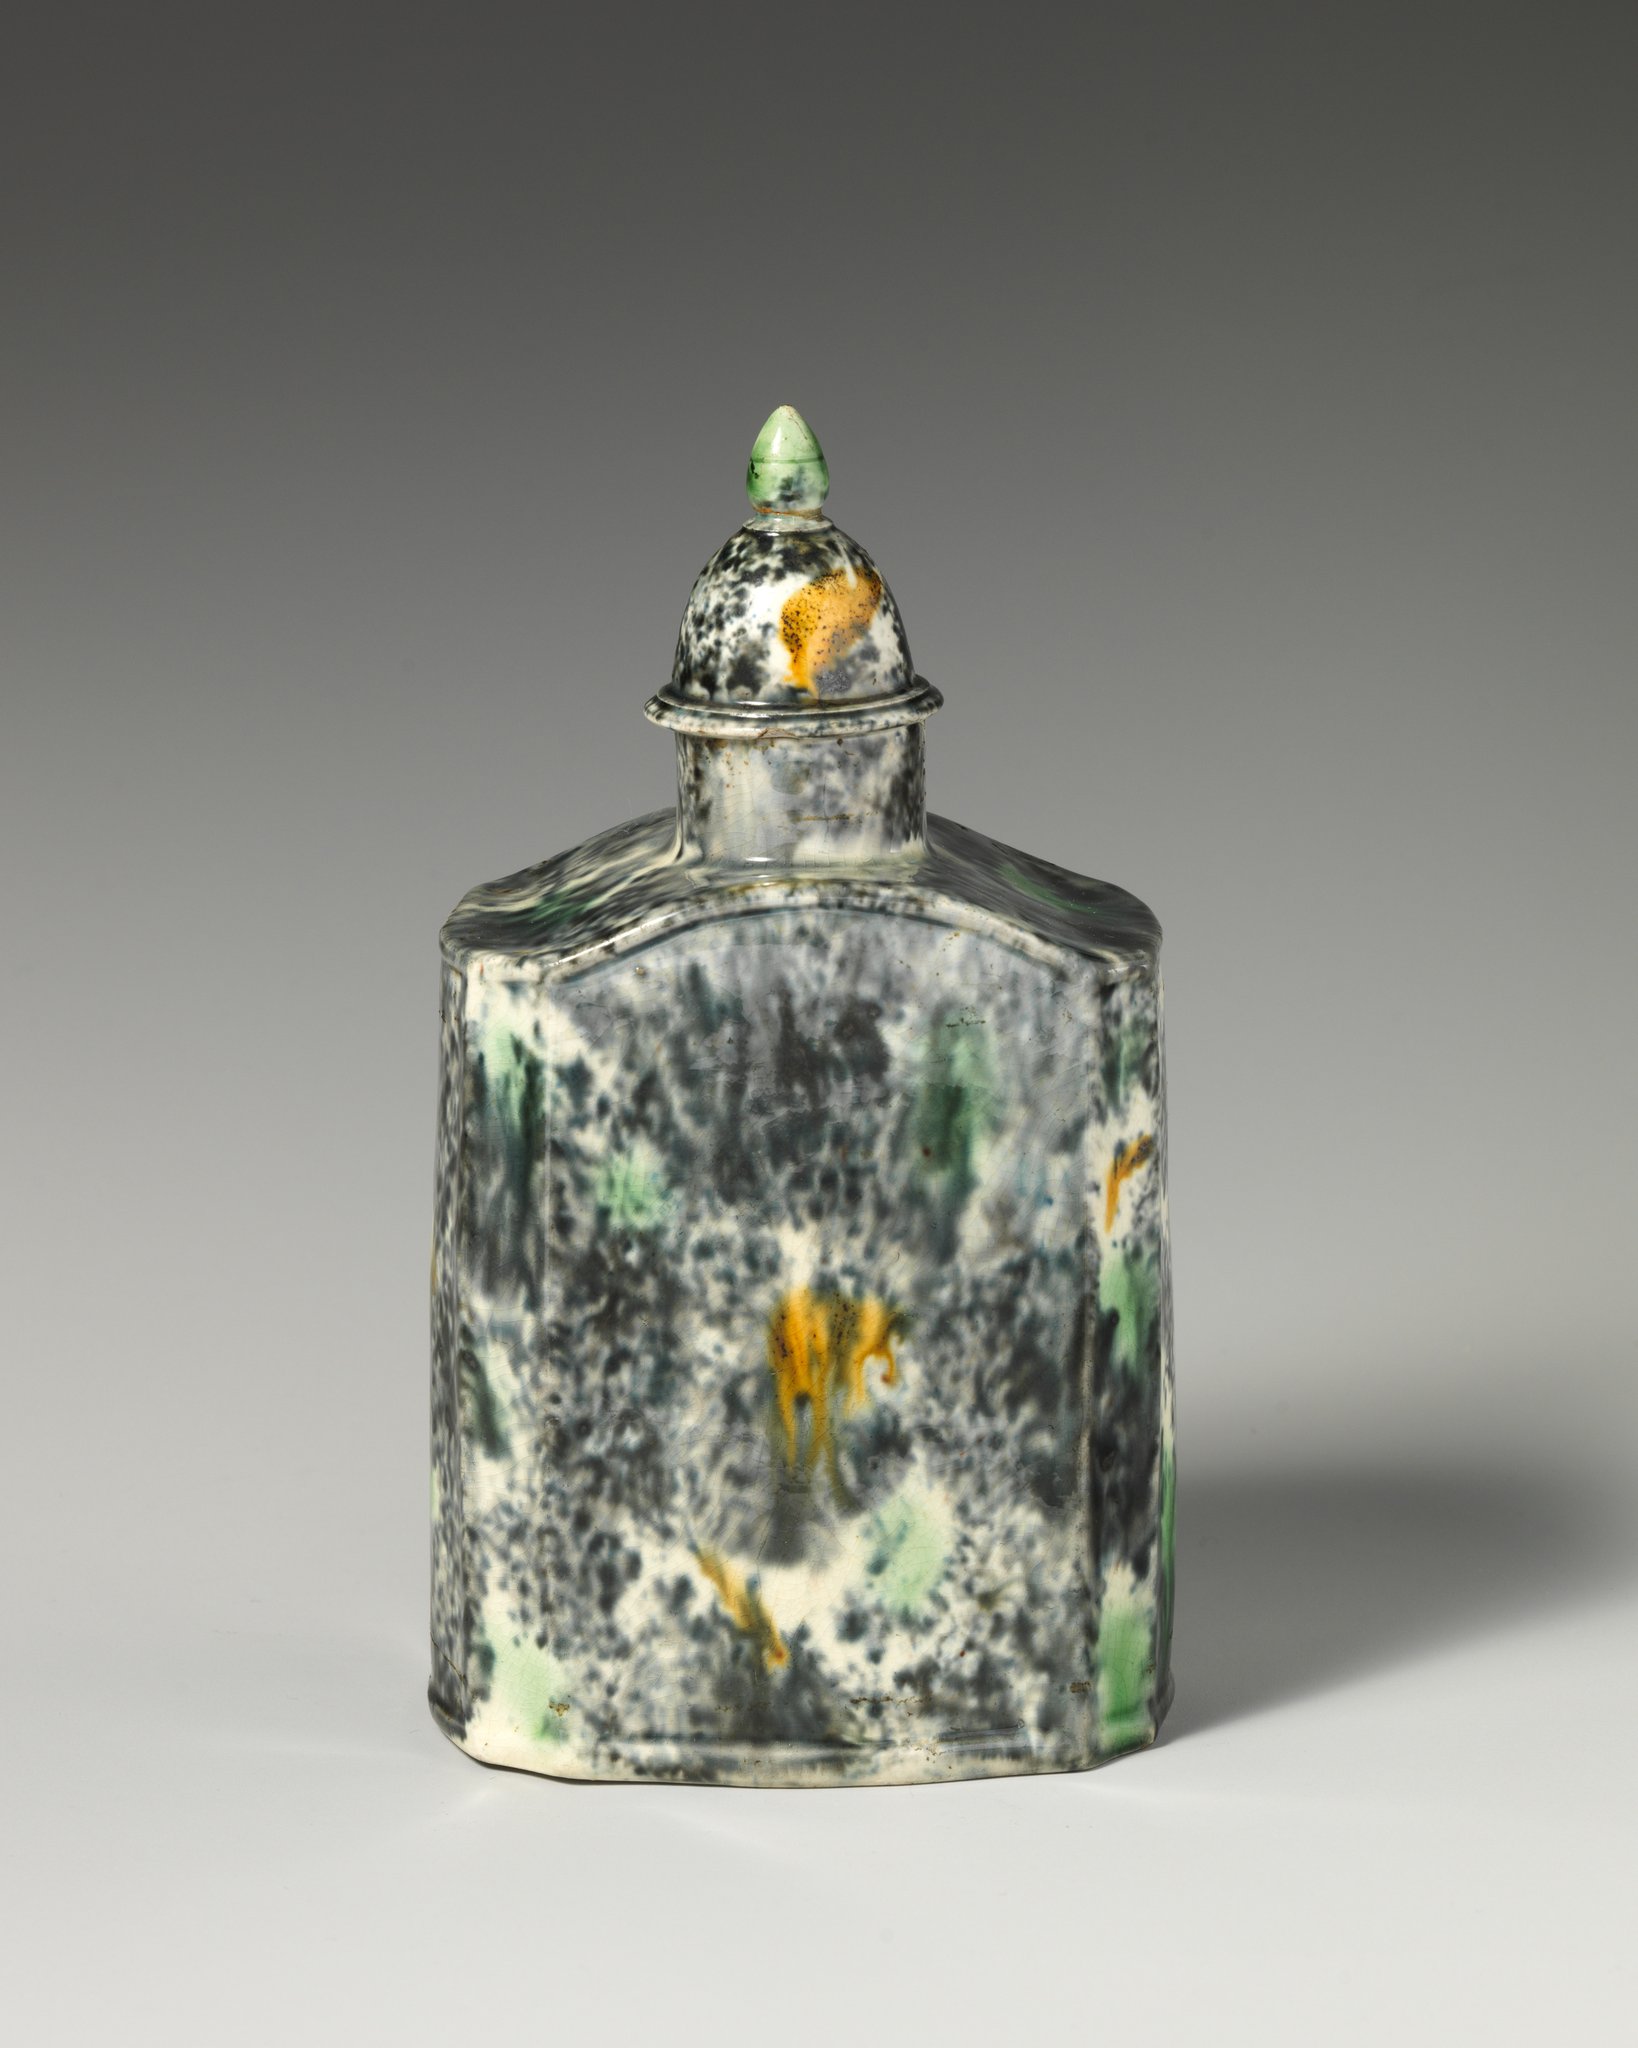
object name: tea caddy with cover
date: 1760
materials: earthenware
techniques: glazing